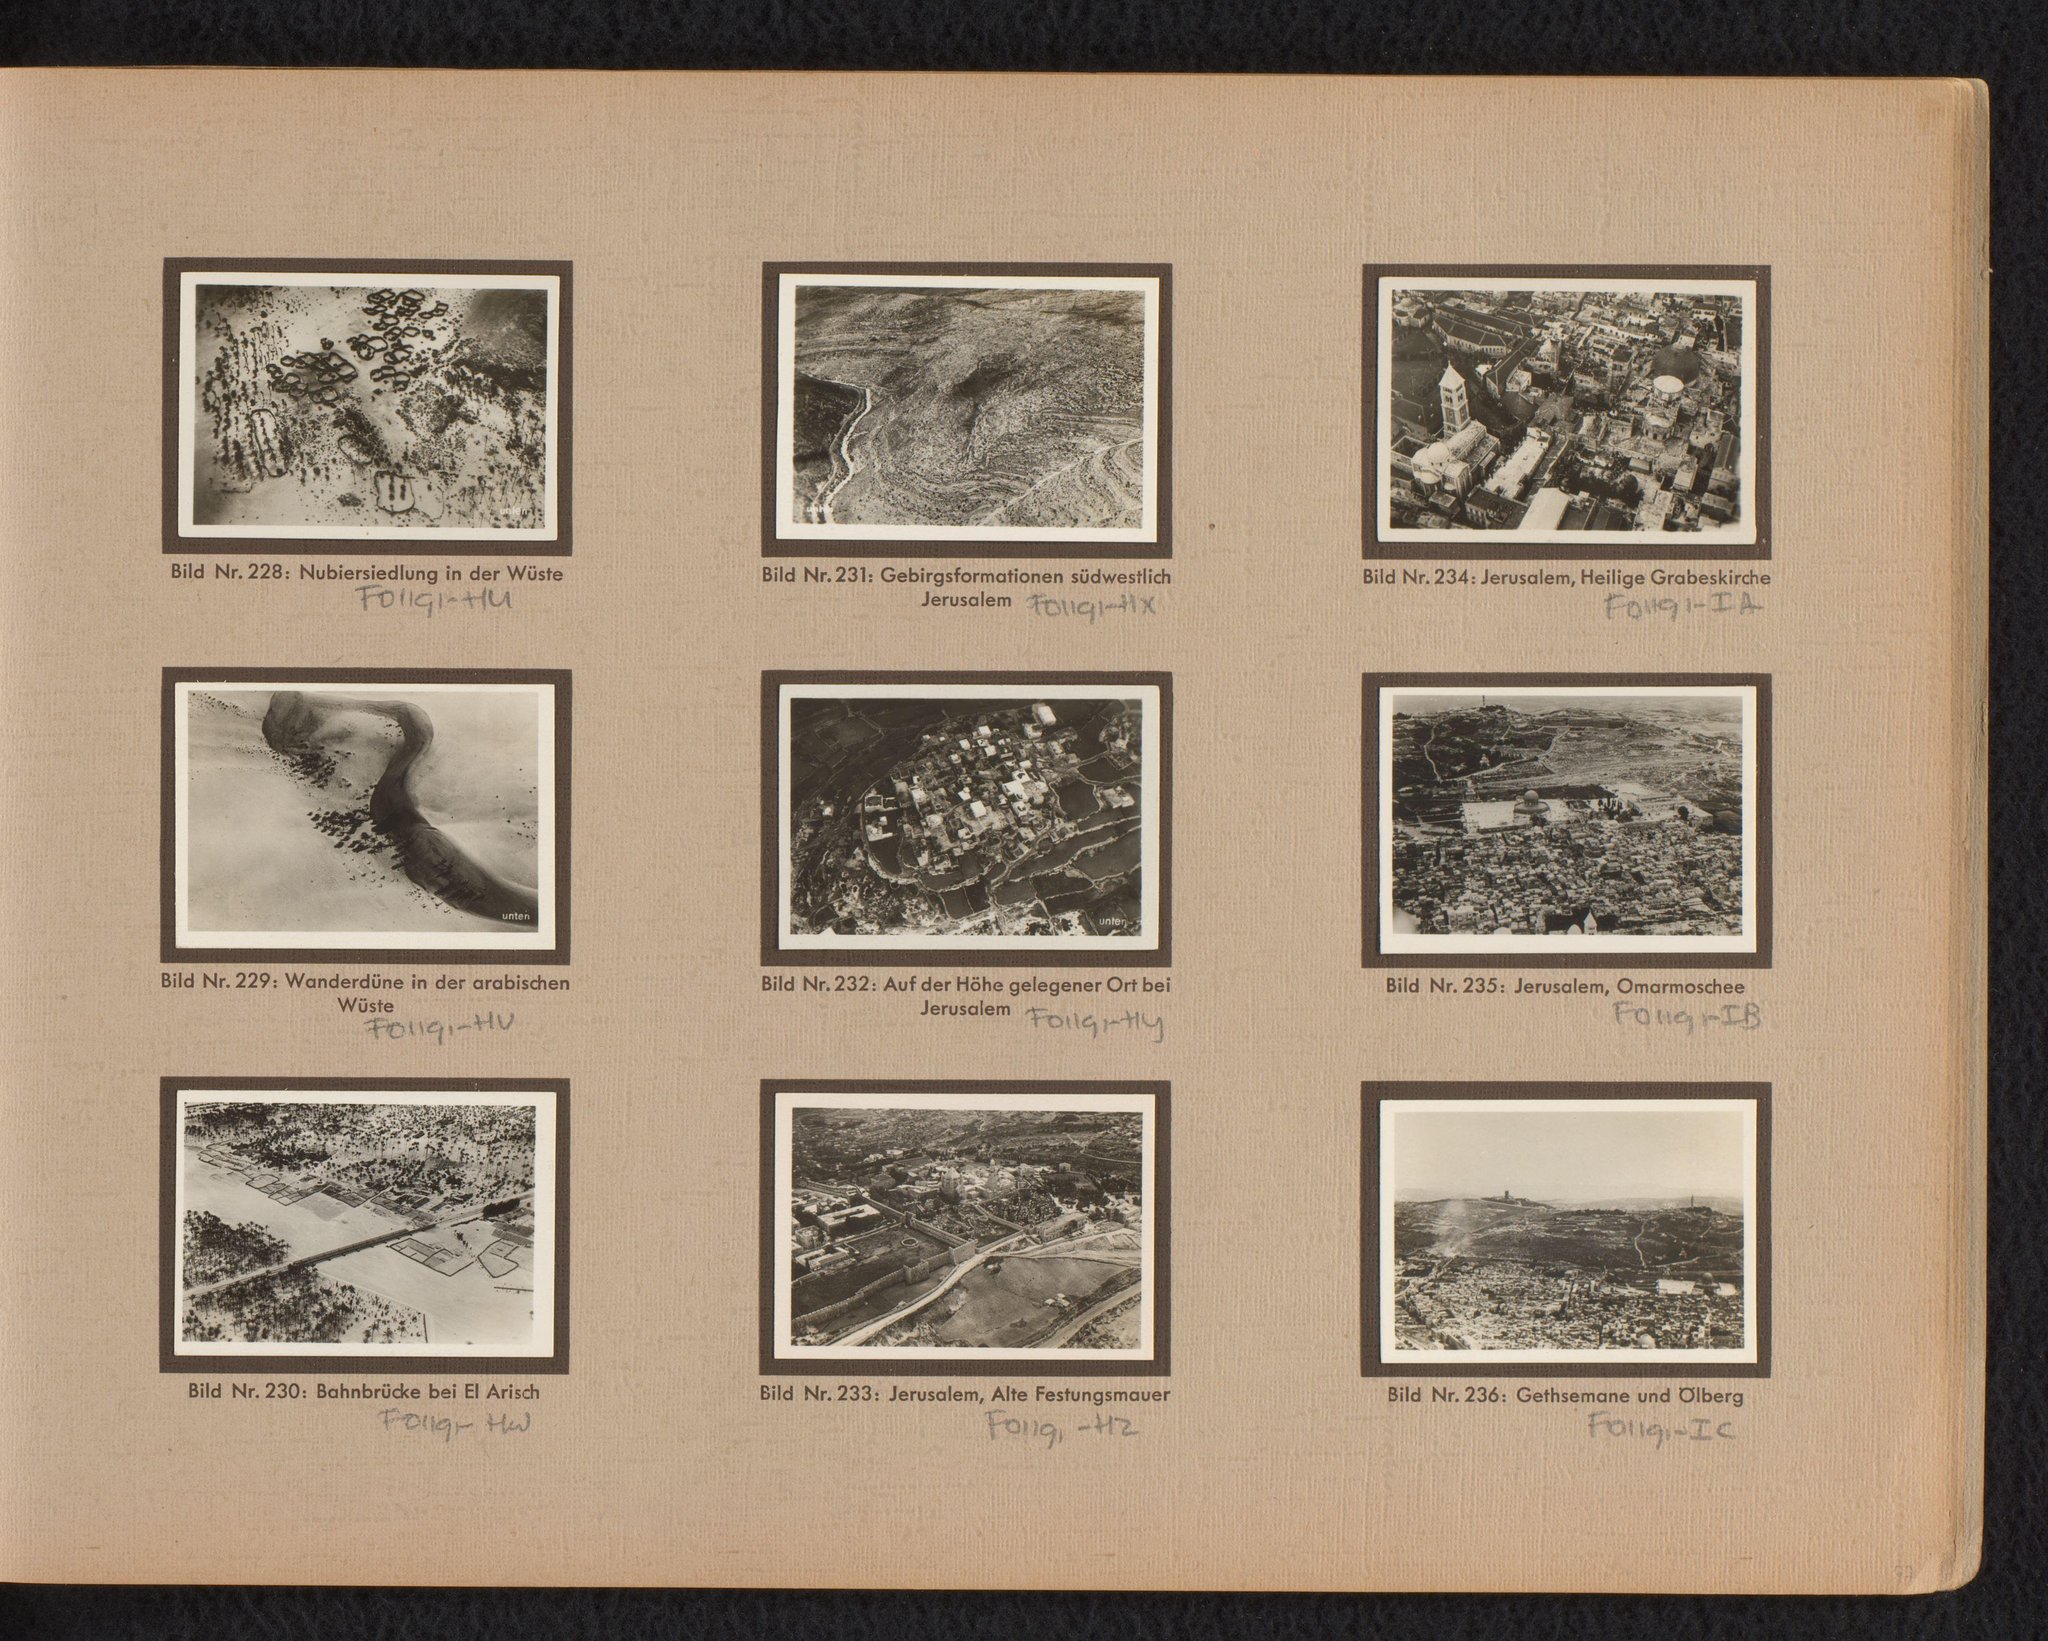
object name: photograph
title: Uitzichten over Israël tijdens een vlucht naar Egypte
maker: Anonymous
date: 1930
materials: paper, photographic support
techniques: gelatin silver print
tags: city-view, and landscape with man-made constructions, church (exterior), temple, shrine ~ islam, mohammedanism, mountains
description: Negen foto's van Israël, gemaakt tijdens een vlucht naar Egypte, waaronder gezichten op de Heilige Grafkerk te Jeruzalem, de Omarmoskee te Jeruzalem, oude vestingmuren van Jeruzalem, Getsemane en de Olijfberg. Op sommige foto's is de schaduw van de zeppelin te zien. Alle foto's zijn voorzien van een nummer en titel. Deze pagina maakt deel uit van een album.